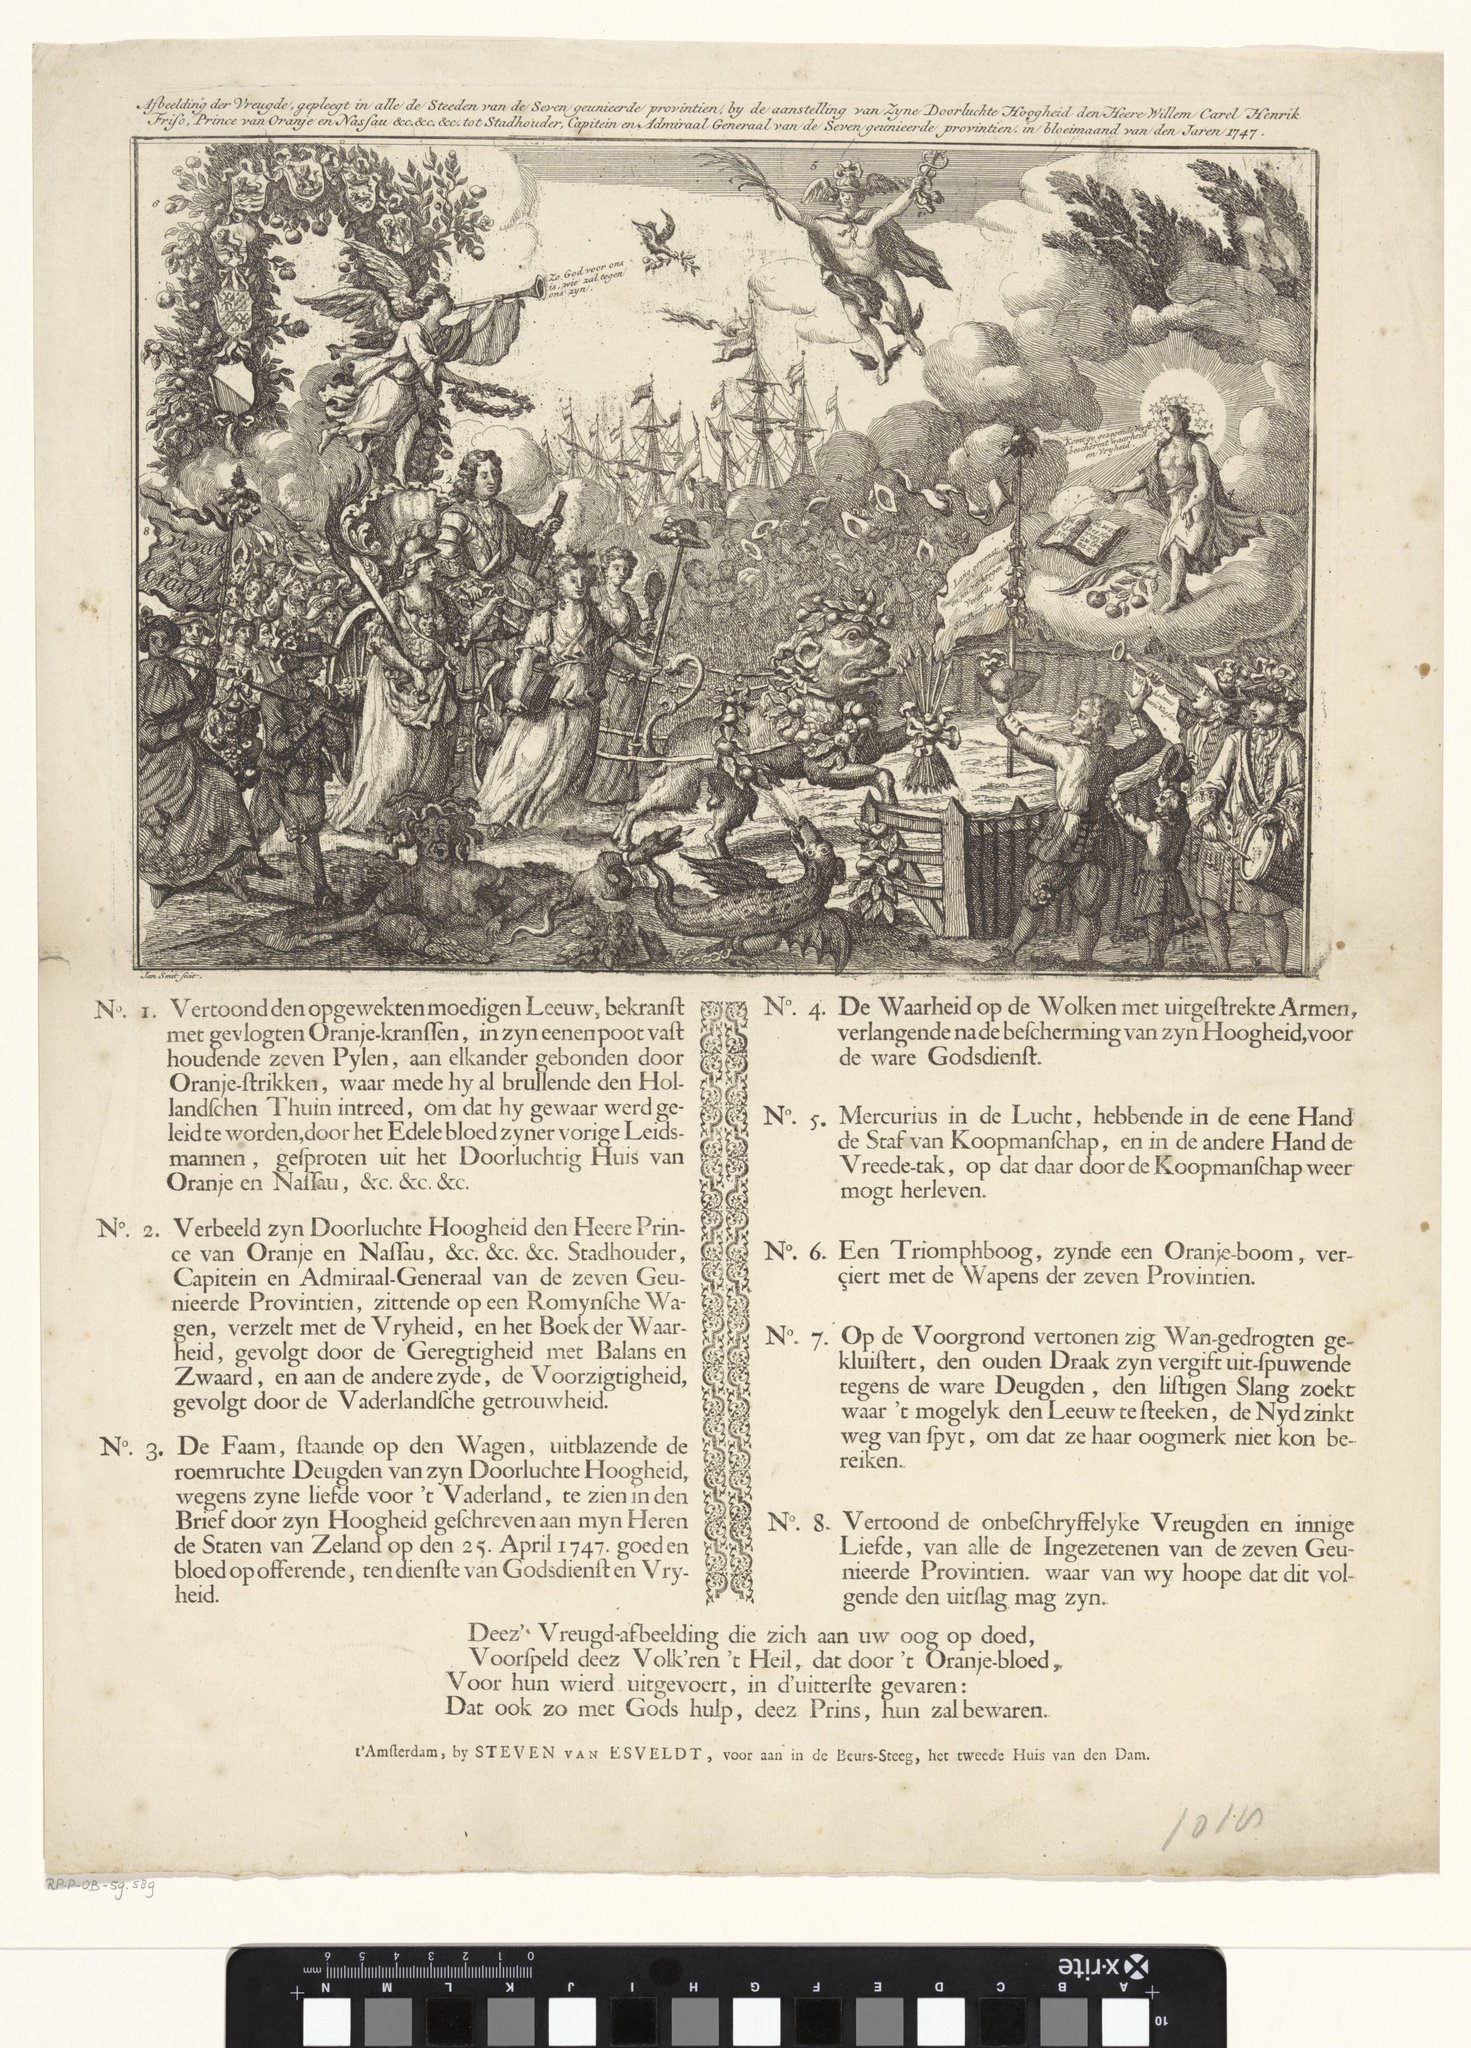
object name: print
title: Allegorie op de aanstelling van Willem IV tot stadhouder van de Republiek, 1747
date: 1747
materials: paper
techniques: engraving, etching, letterpress printing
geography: amsterdam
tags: willem iv (prins van oranje-nassau), chariot, triumphal car, symbolic triumphs of individual persons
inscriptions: collector's mark: Lugt 2228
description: Allegorie op de aanstelling van prins Willem IV tot stadhouder van de Republiek, mei 1747. Willem IV in triomfwagen getrokken door de Nederlandse Leeuw treedt de Hollandse Tuin binnen, begeleid door Minerva, Vrijheid en Voorzichtigheid. In de lucht de Faam en Mercurius, rechts de Waarheid in de wolken, op de voor- en achtergrond juichende ingezetenen. Op het blad onder de plaat de verklaring van de cijfers 1-8 en een vierregelig vers.